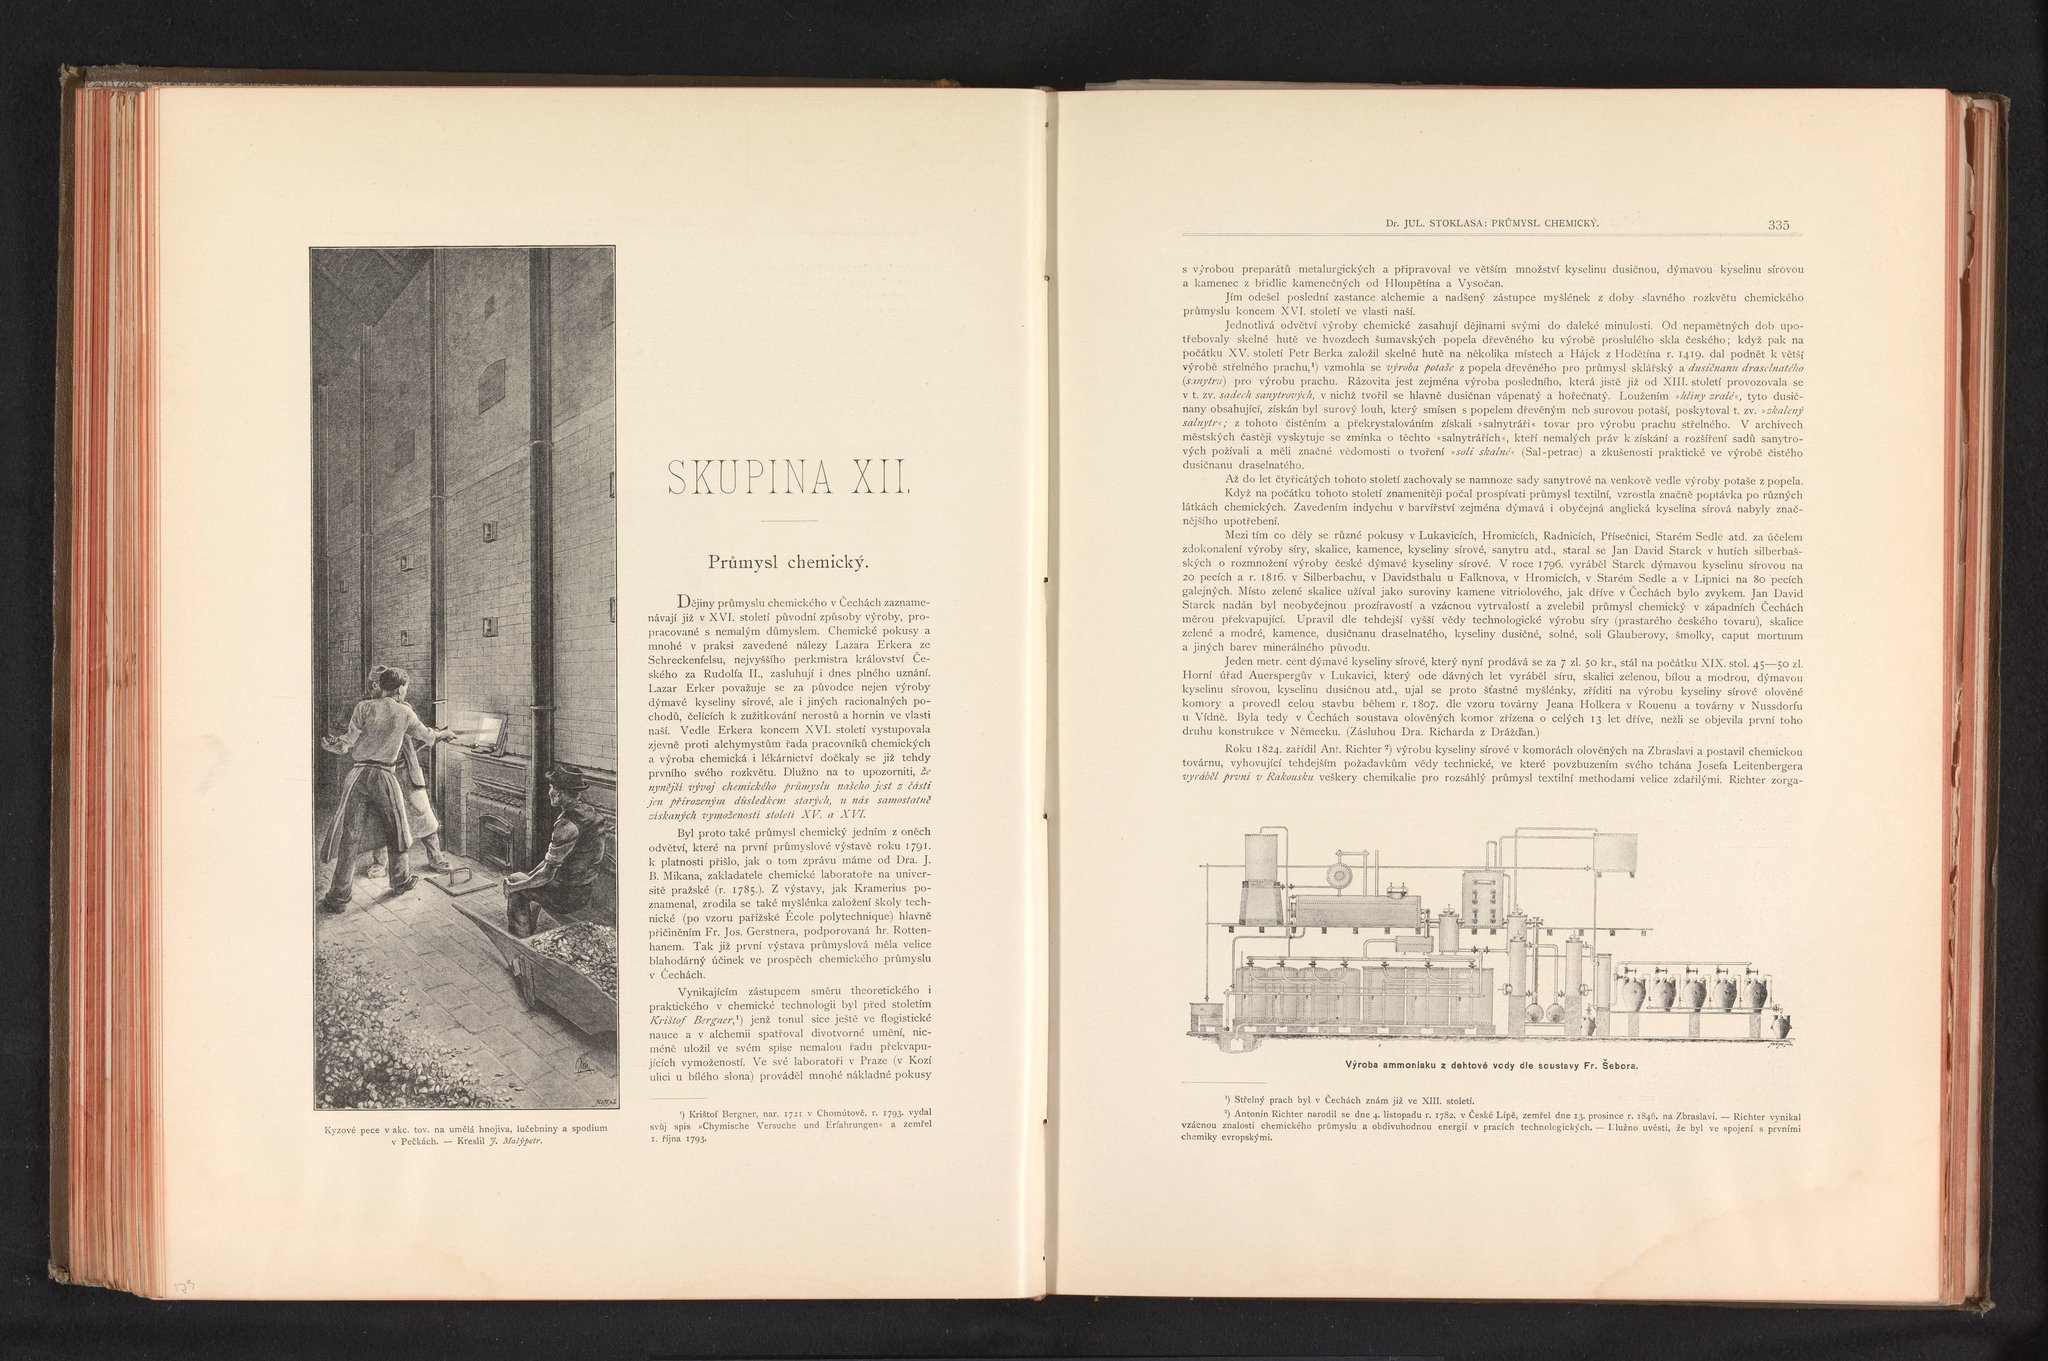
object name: photomechanical print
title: Výroba ammoniaku z dehtové vody dle soustavy Fr. Sebora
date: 1890-1895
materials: paper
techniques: autotype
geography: prague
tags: machines; parts of machines; tools and appliances